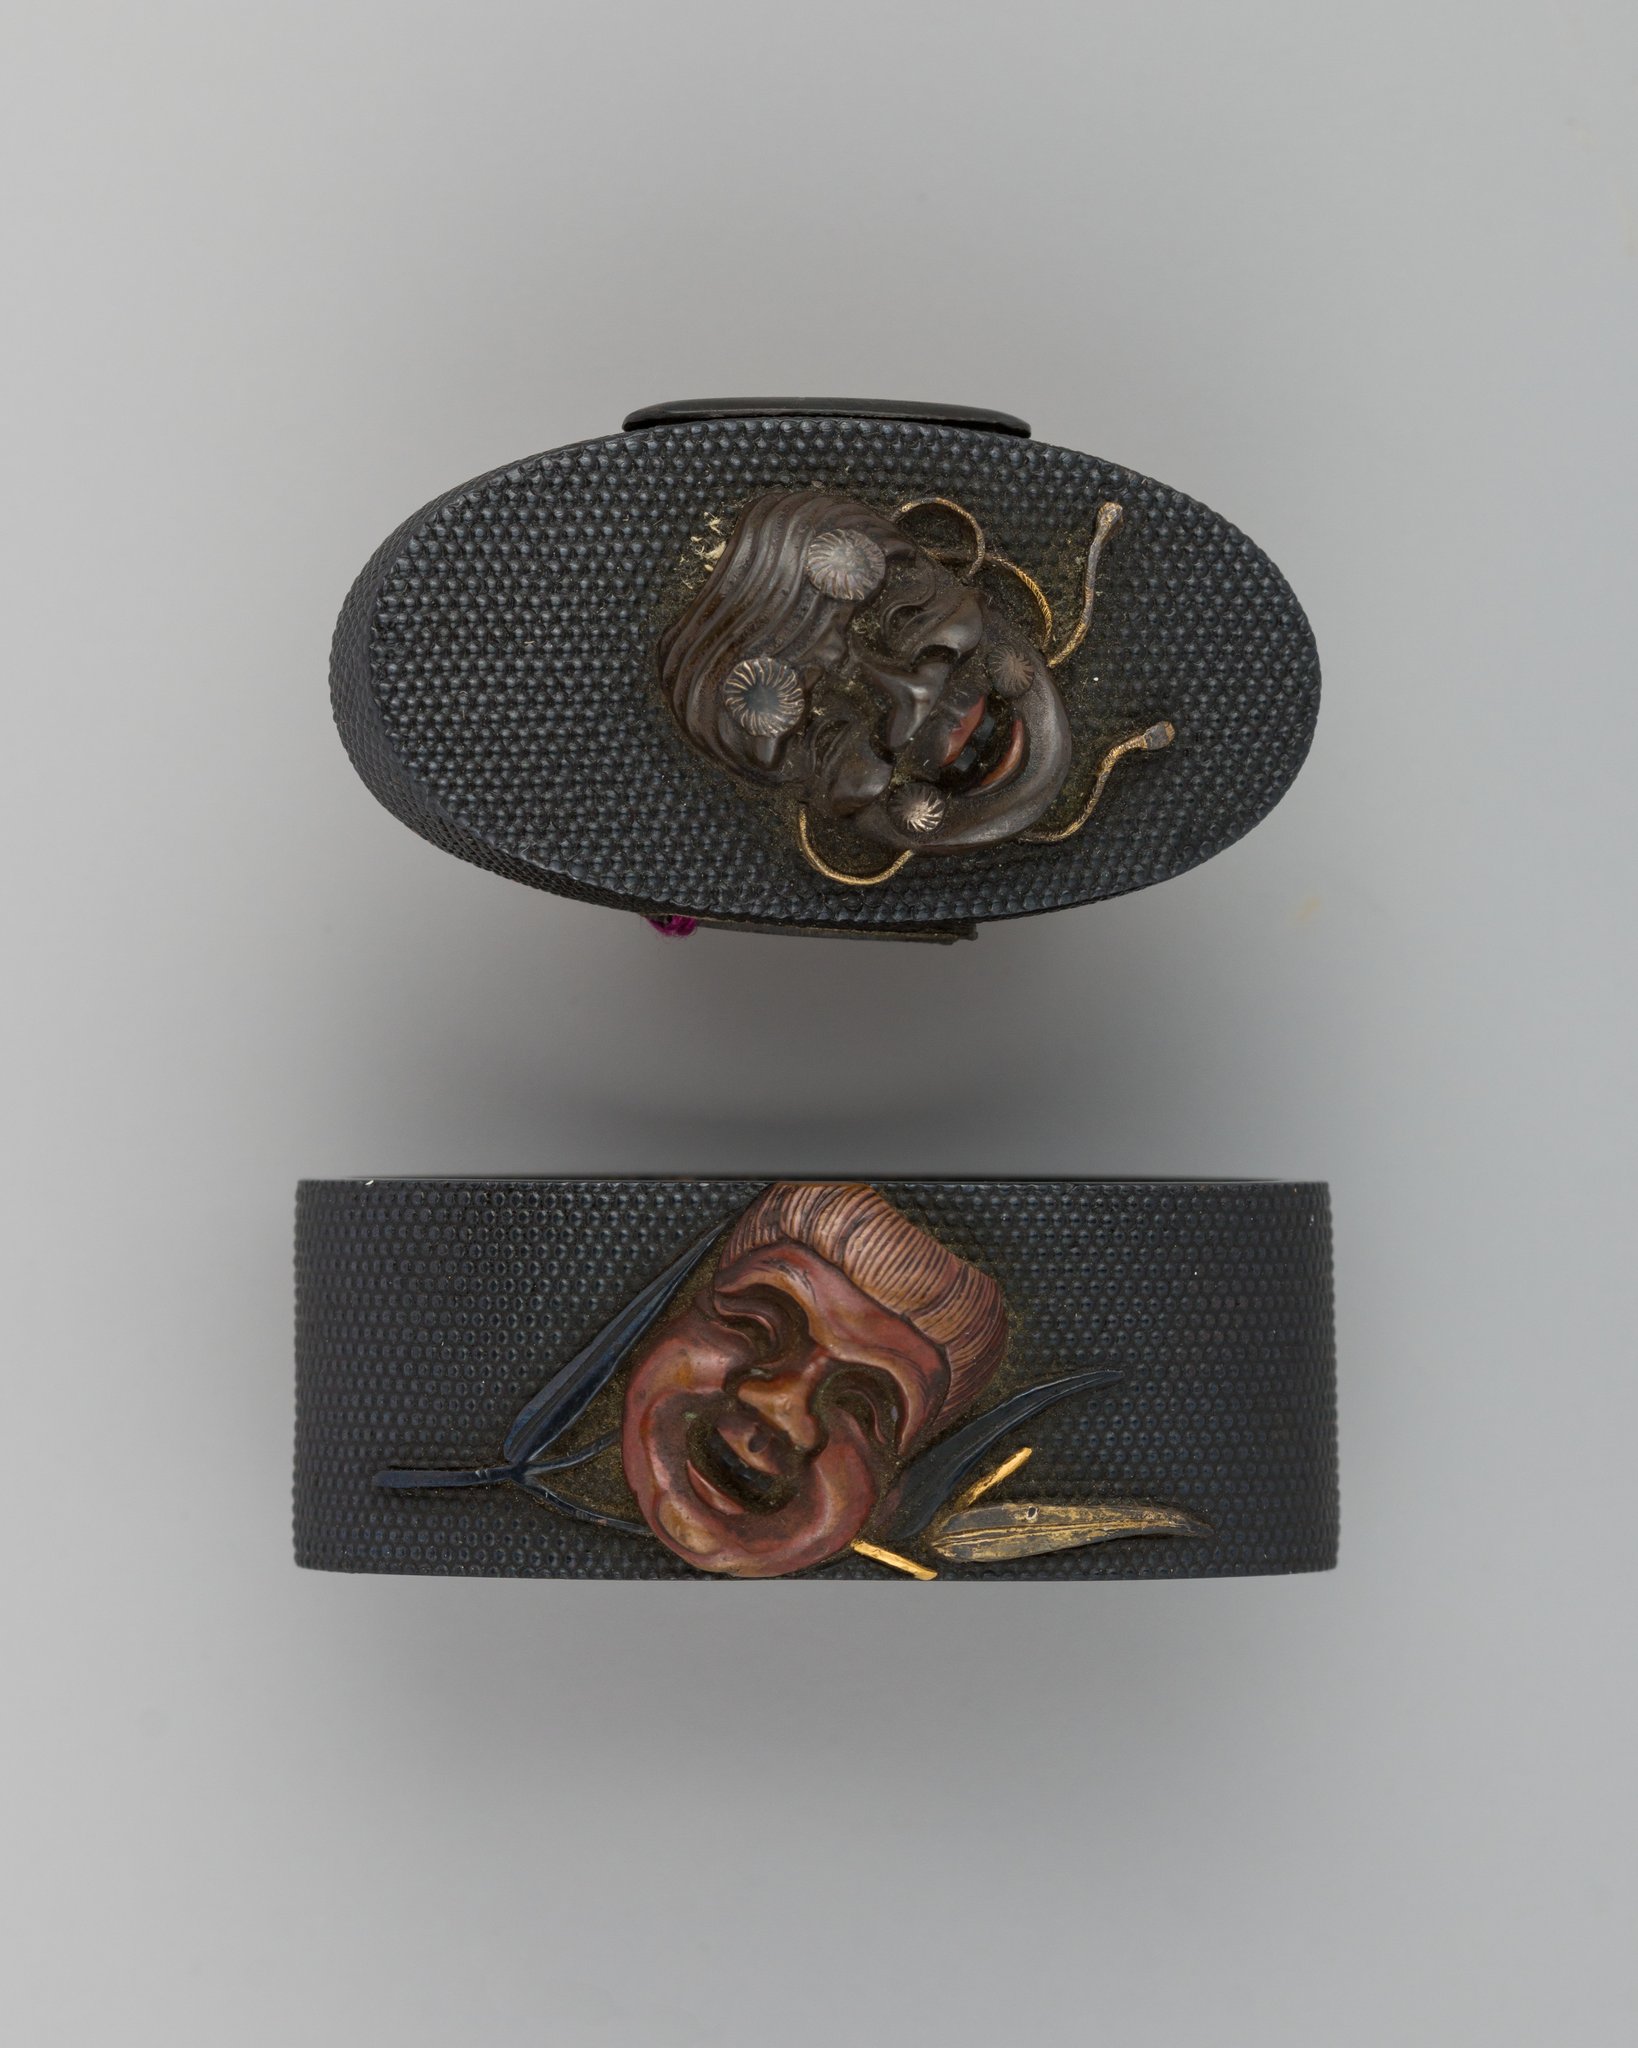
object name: sword hilt collar and pommel fuchigashira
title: Sword-Hilt Collar and Pommel (Fuchigashira)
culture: japanese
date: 1615-1868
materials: copper, gold alloy, silver alloy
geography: japan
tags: faces